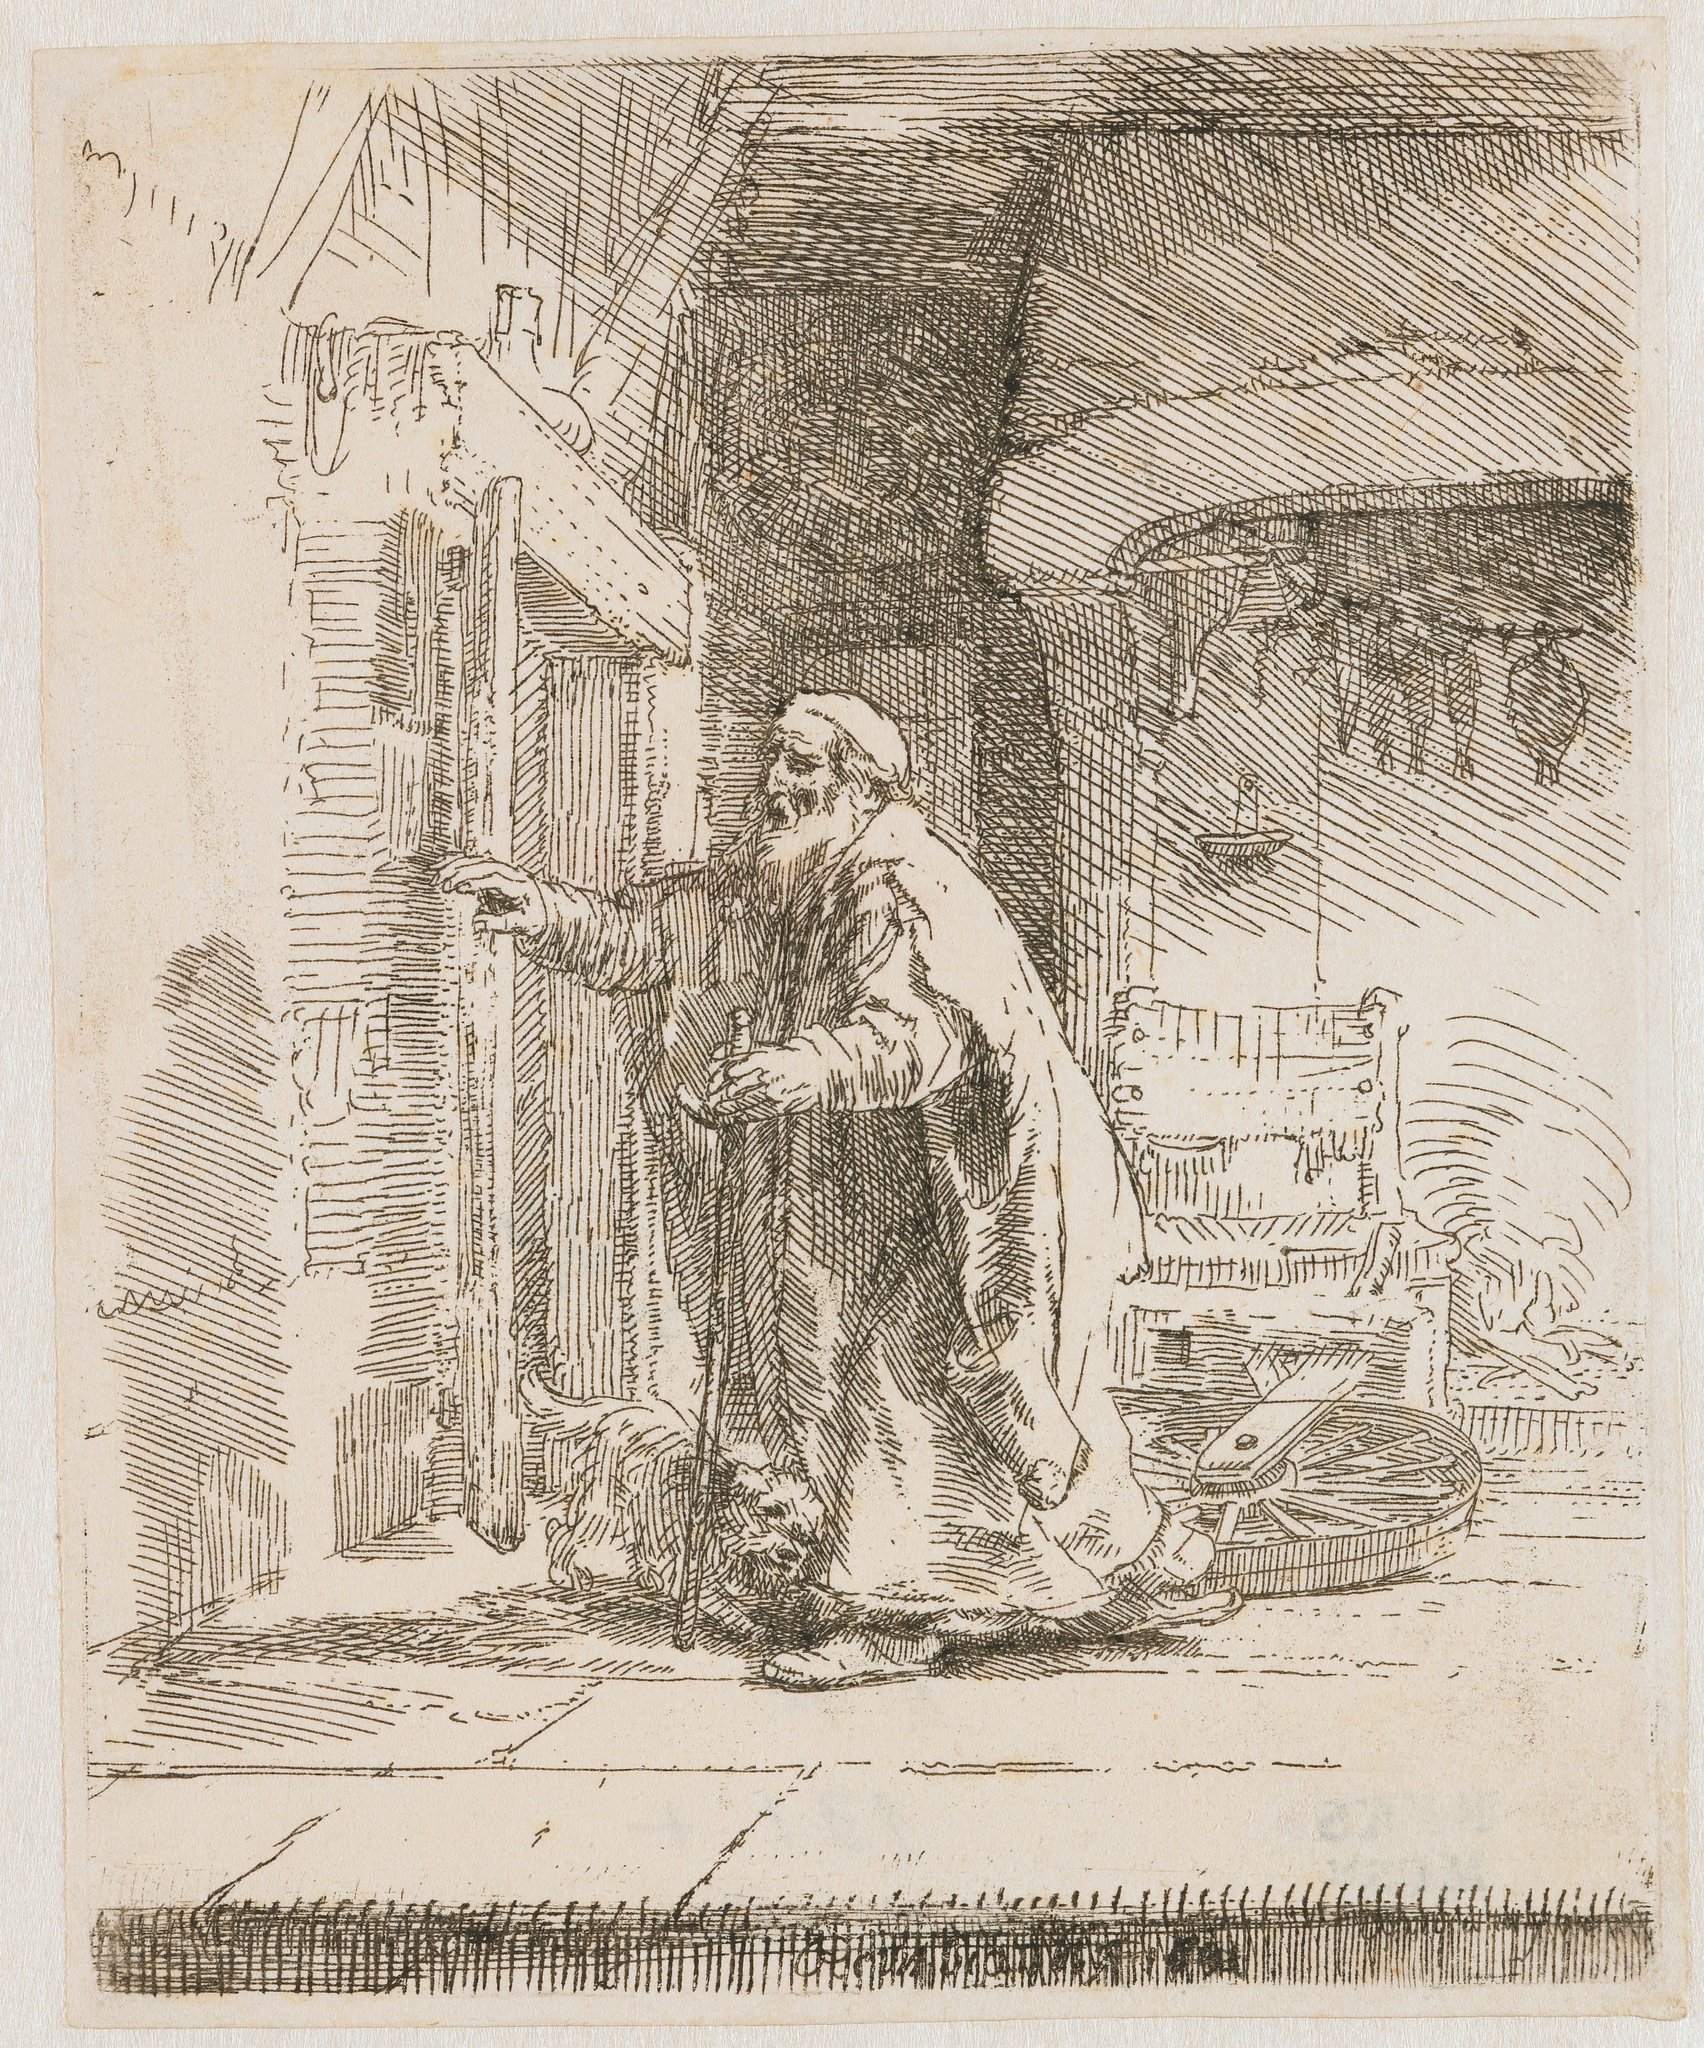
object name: print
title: The blindness of Tobit: the larger plate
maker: rembrandt van rijn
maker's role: draughtsman, painter, print maker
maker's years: 1606-1669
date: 1651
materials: paper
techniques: drypoint, etching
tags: tobit's blindness (tobit 2 - 3:6)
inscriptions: signature and date: ‘Rembrandt f. 1651’, mark: Lugt 2165